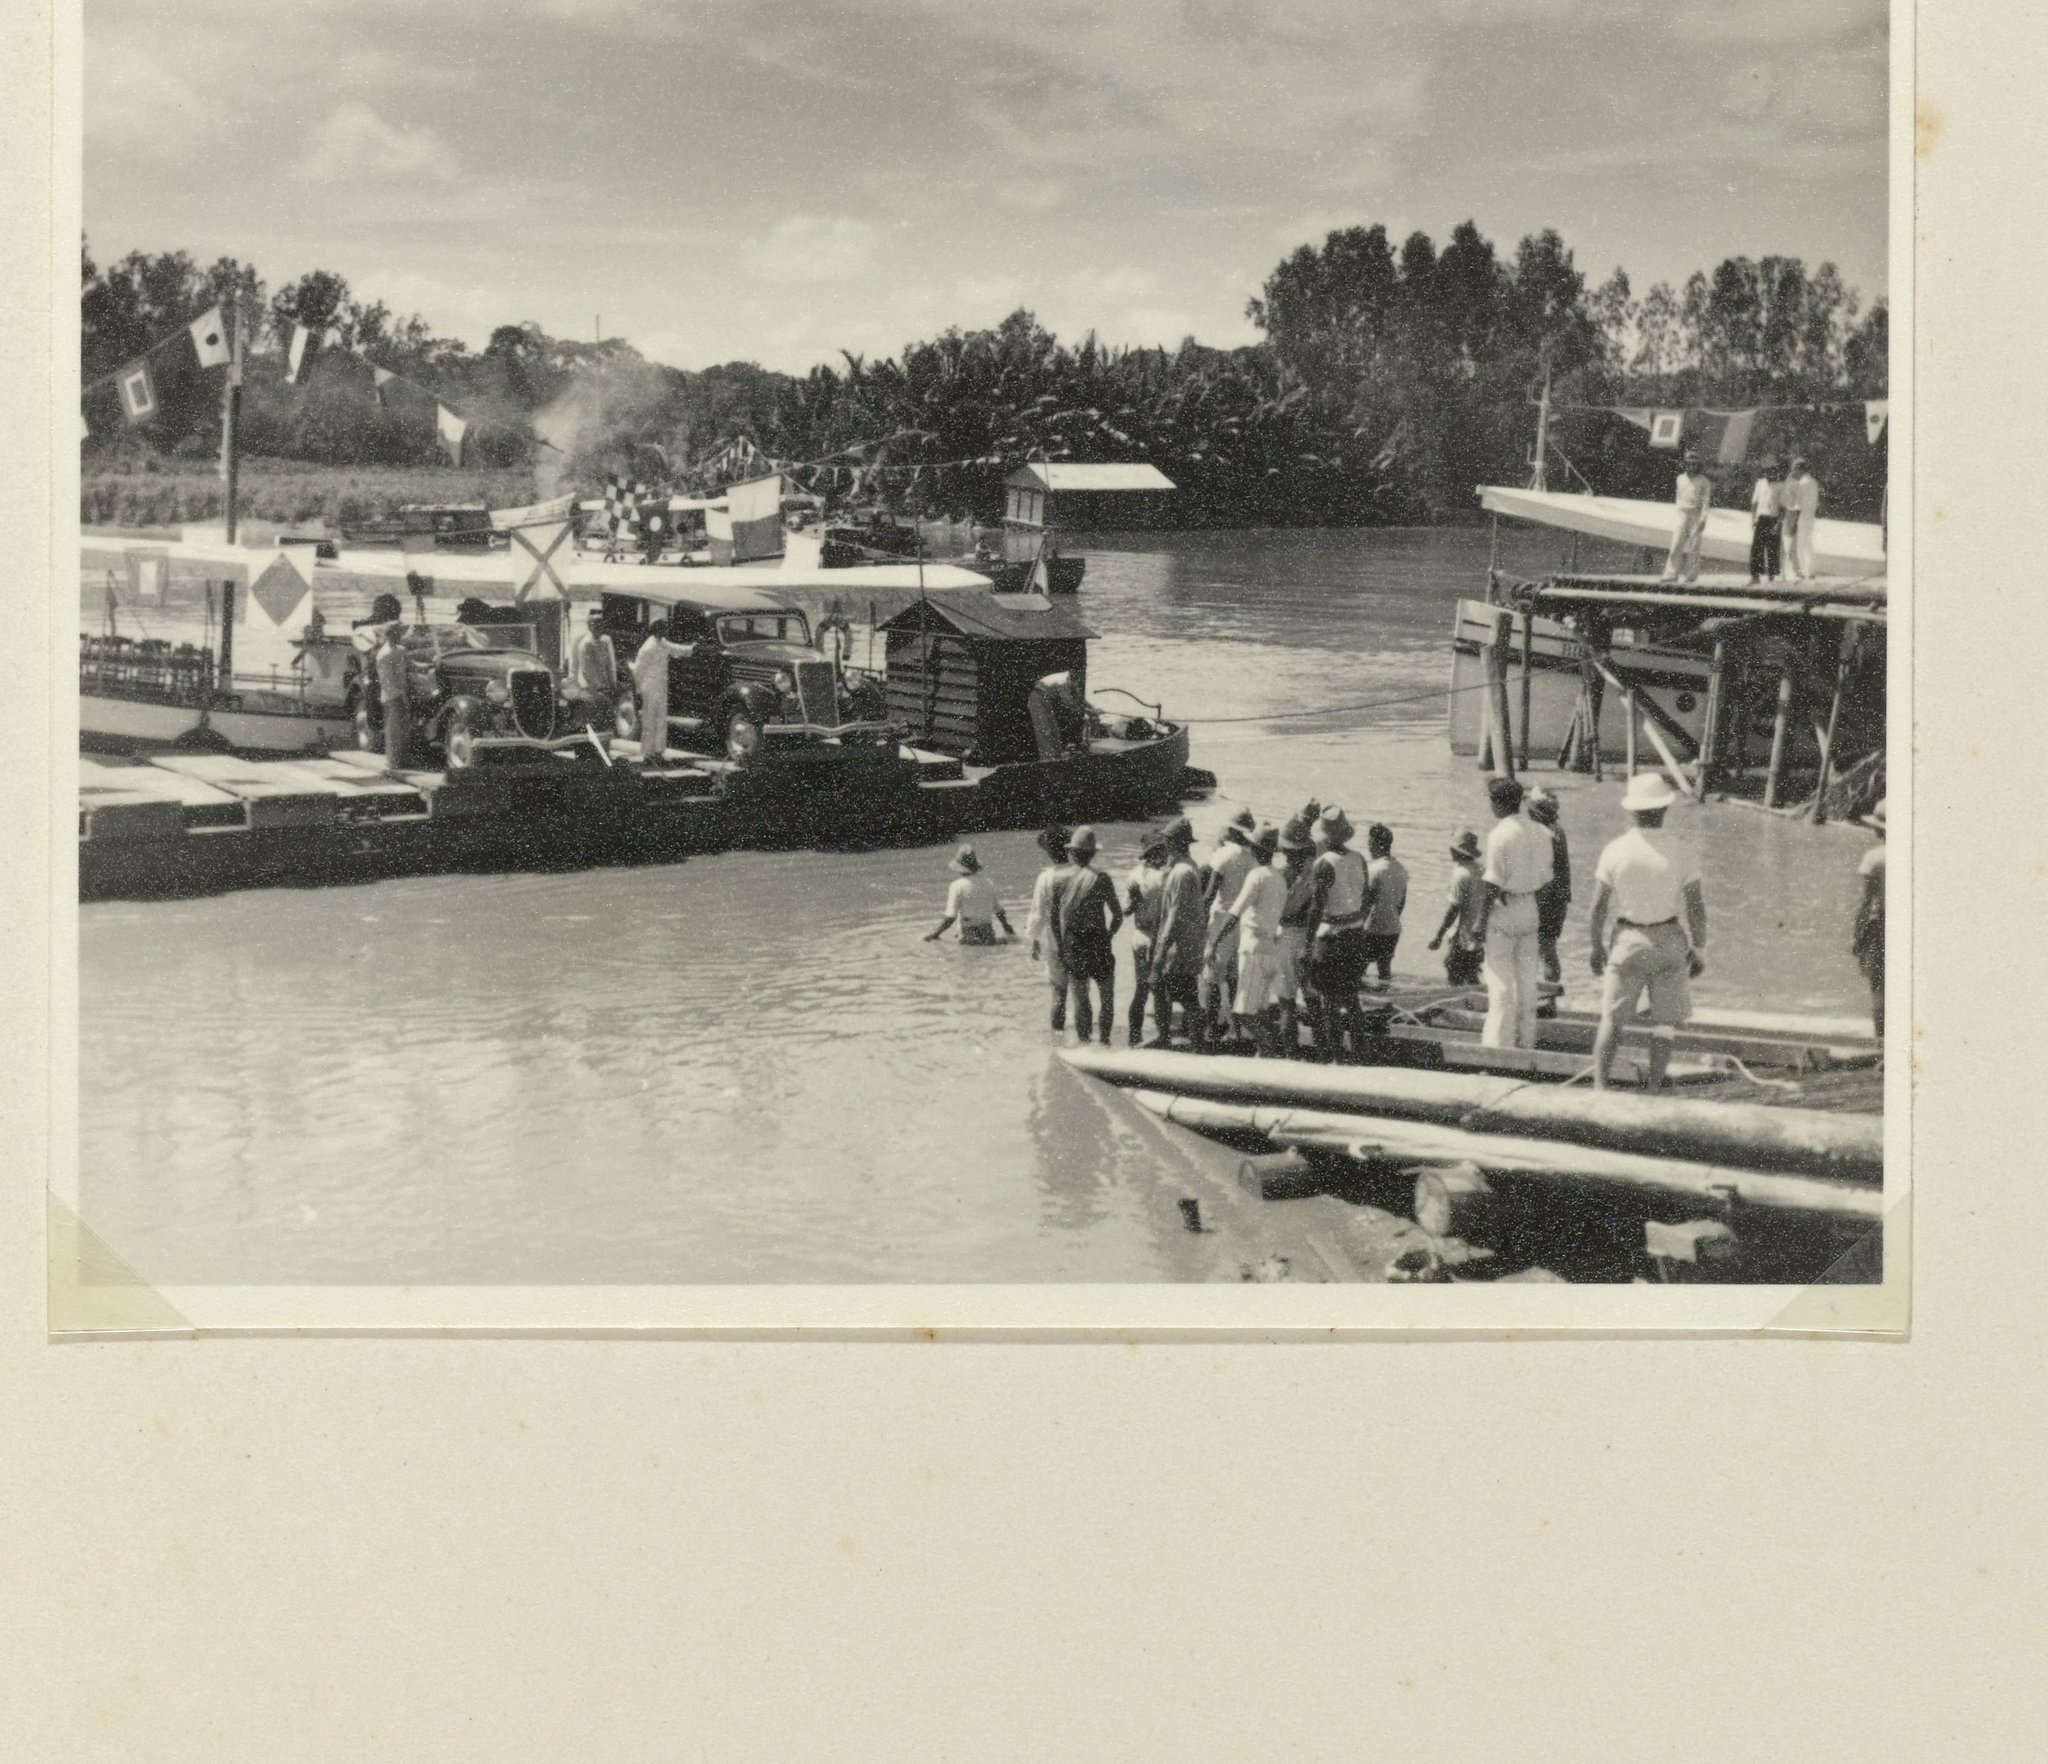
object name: photograph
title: Overzetten van auto's op een boot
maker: Anonymous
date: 1935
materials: photographic support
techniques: gelatin silver print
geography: sumatra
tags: utrecht, germany, colonial system, pipeline ~transportation of oil, ferry, pier, quay, wharf, commemoration, jubilee, automobile, sumatra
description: Het overzetten van twee auto's op een boot, op de voorgrond een steiger met de afrit. Foto in het fotoalbum samengesteld ter gelegenheid van de feestelijke ingebruikstelling van de pijpleiding van Tempino naar Pladjoe op Sumatra door de Nederlandsch-Indische Aardolie Maatschappij (NIAM) op 15 november 1935.